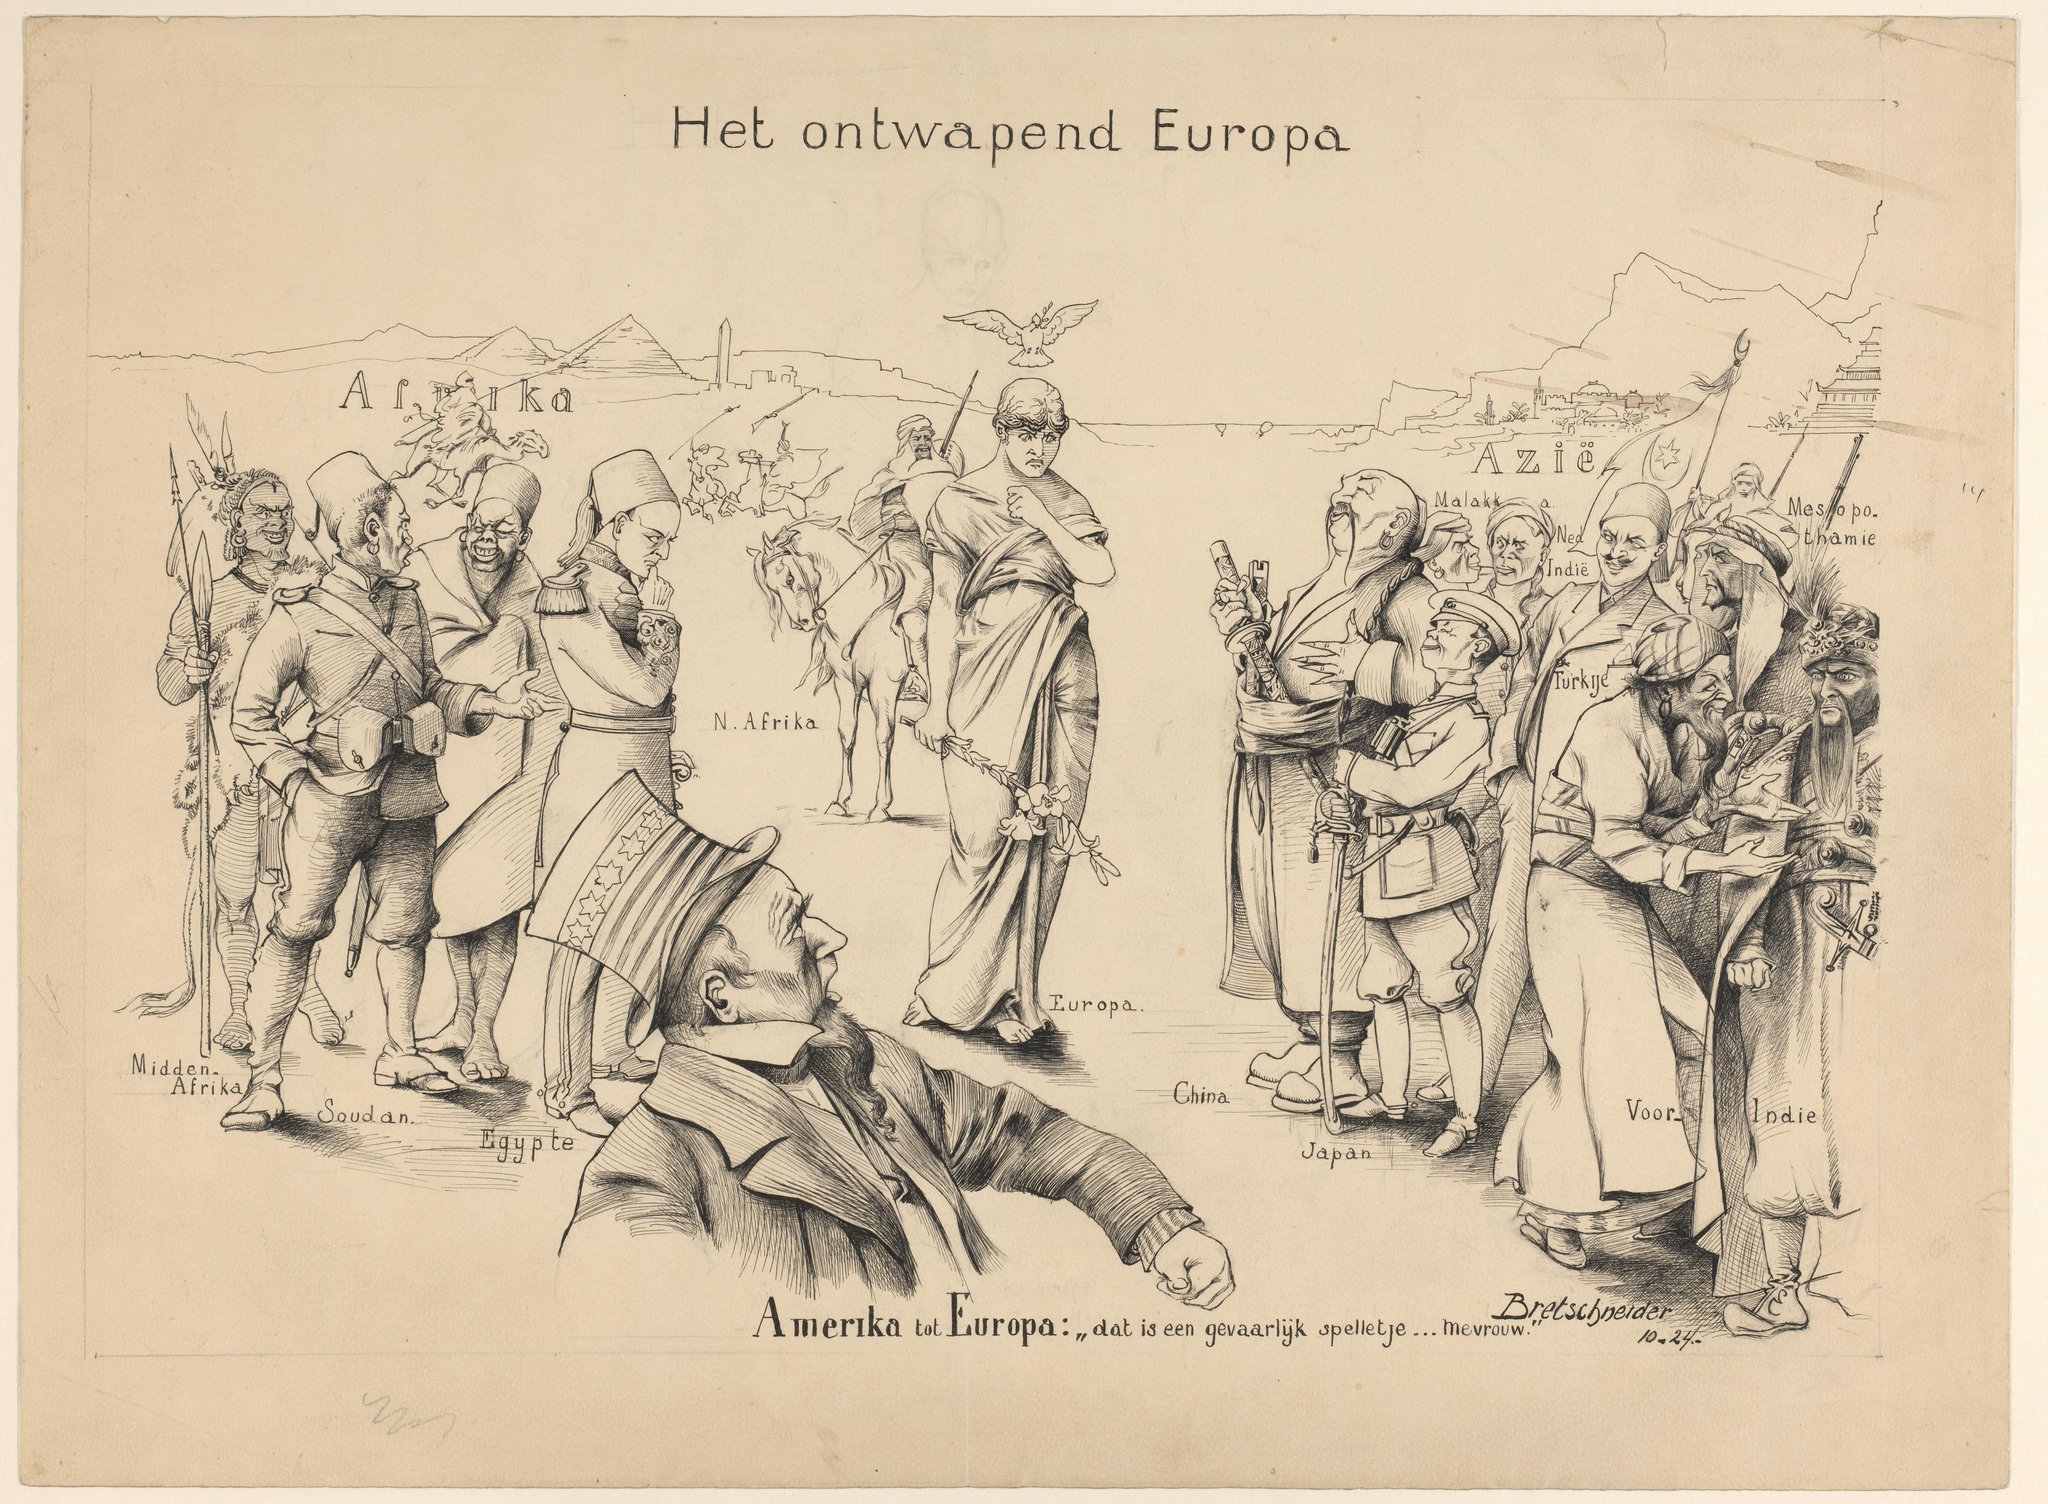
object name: drawing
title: Het ontwapend Europa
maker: j. bretschneider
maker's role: draughtsman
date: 1910-1924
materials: ink, paper, pencil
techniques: pen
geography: netherlands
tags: personifications of countries, nations, states, districts, etc., symbols, allegories of peace, 'pax'; 'pace' (ripa), disarmament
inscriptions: collector's mark: Lugt 2228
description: Spotprent op de kwetsbare positie van een ontwapend Europa in de wereld, oktober 1924. De vrouw Europa spottend gadegeslagen door karikaturaal voorgestelde vertegenwoordigers van, links Afrikaanse landen en rechts, Aziatische landen. Op de voorgrond spreekt Uncle Sam (Amerika) Europa kwaad toe.